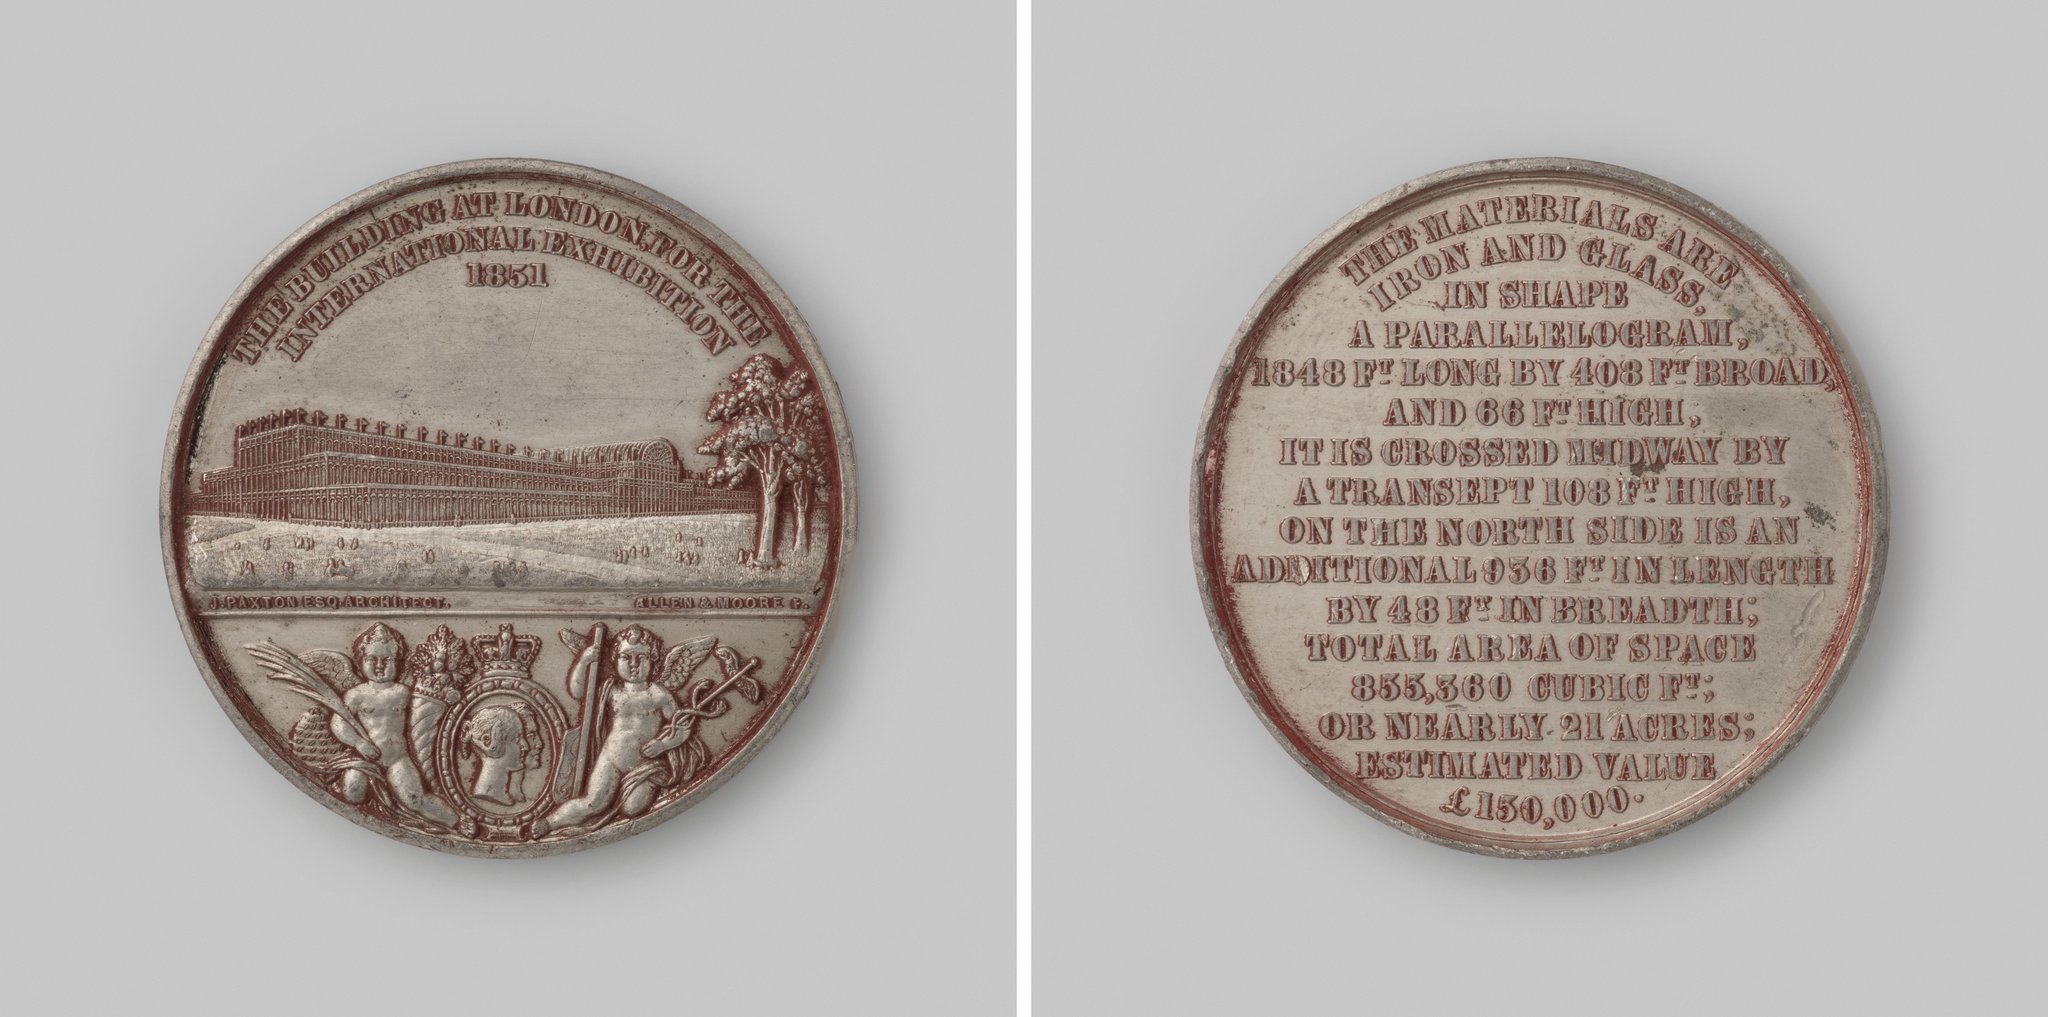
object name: history medal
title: Opening van het gebouw voor de Internationale Tentoonstelling te Londen 1851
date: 1851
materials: tin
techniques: striking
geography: birmingham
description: Tinnen penning, op de voorzijde drie regels tekst, het tentoonstellingsgebouw en een gekroond portretmedaillon tussen twee putti, op de keerzijde zestien regels tekst met omschrift.